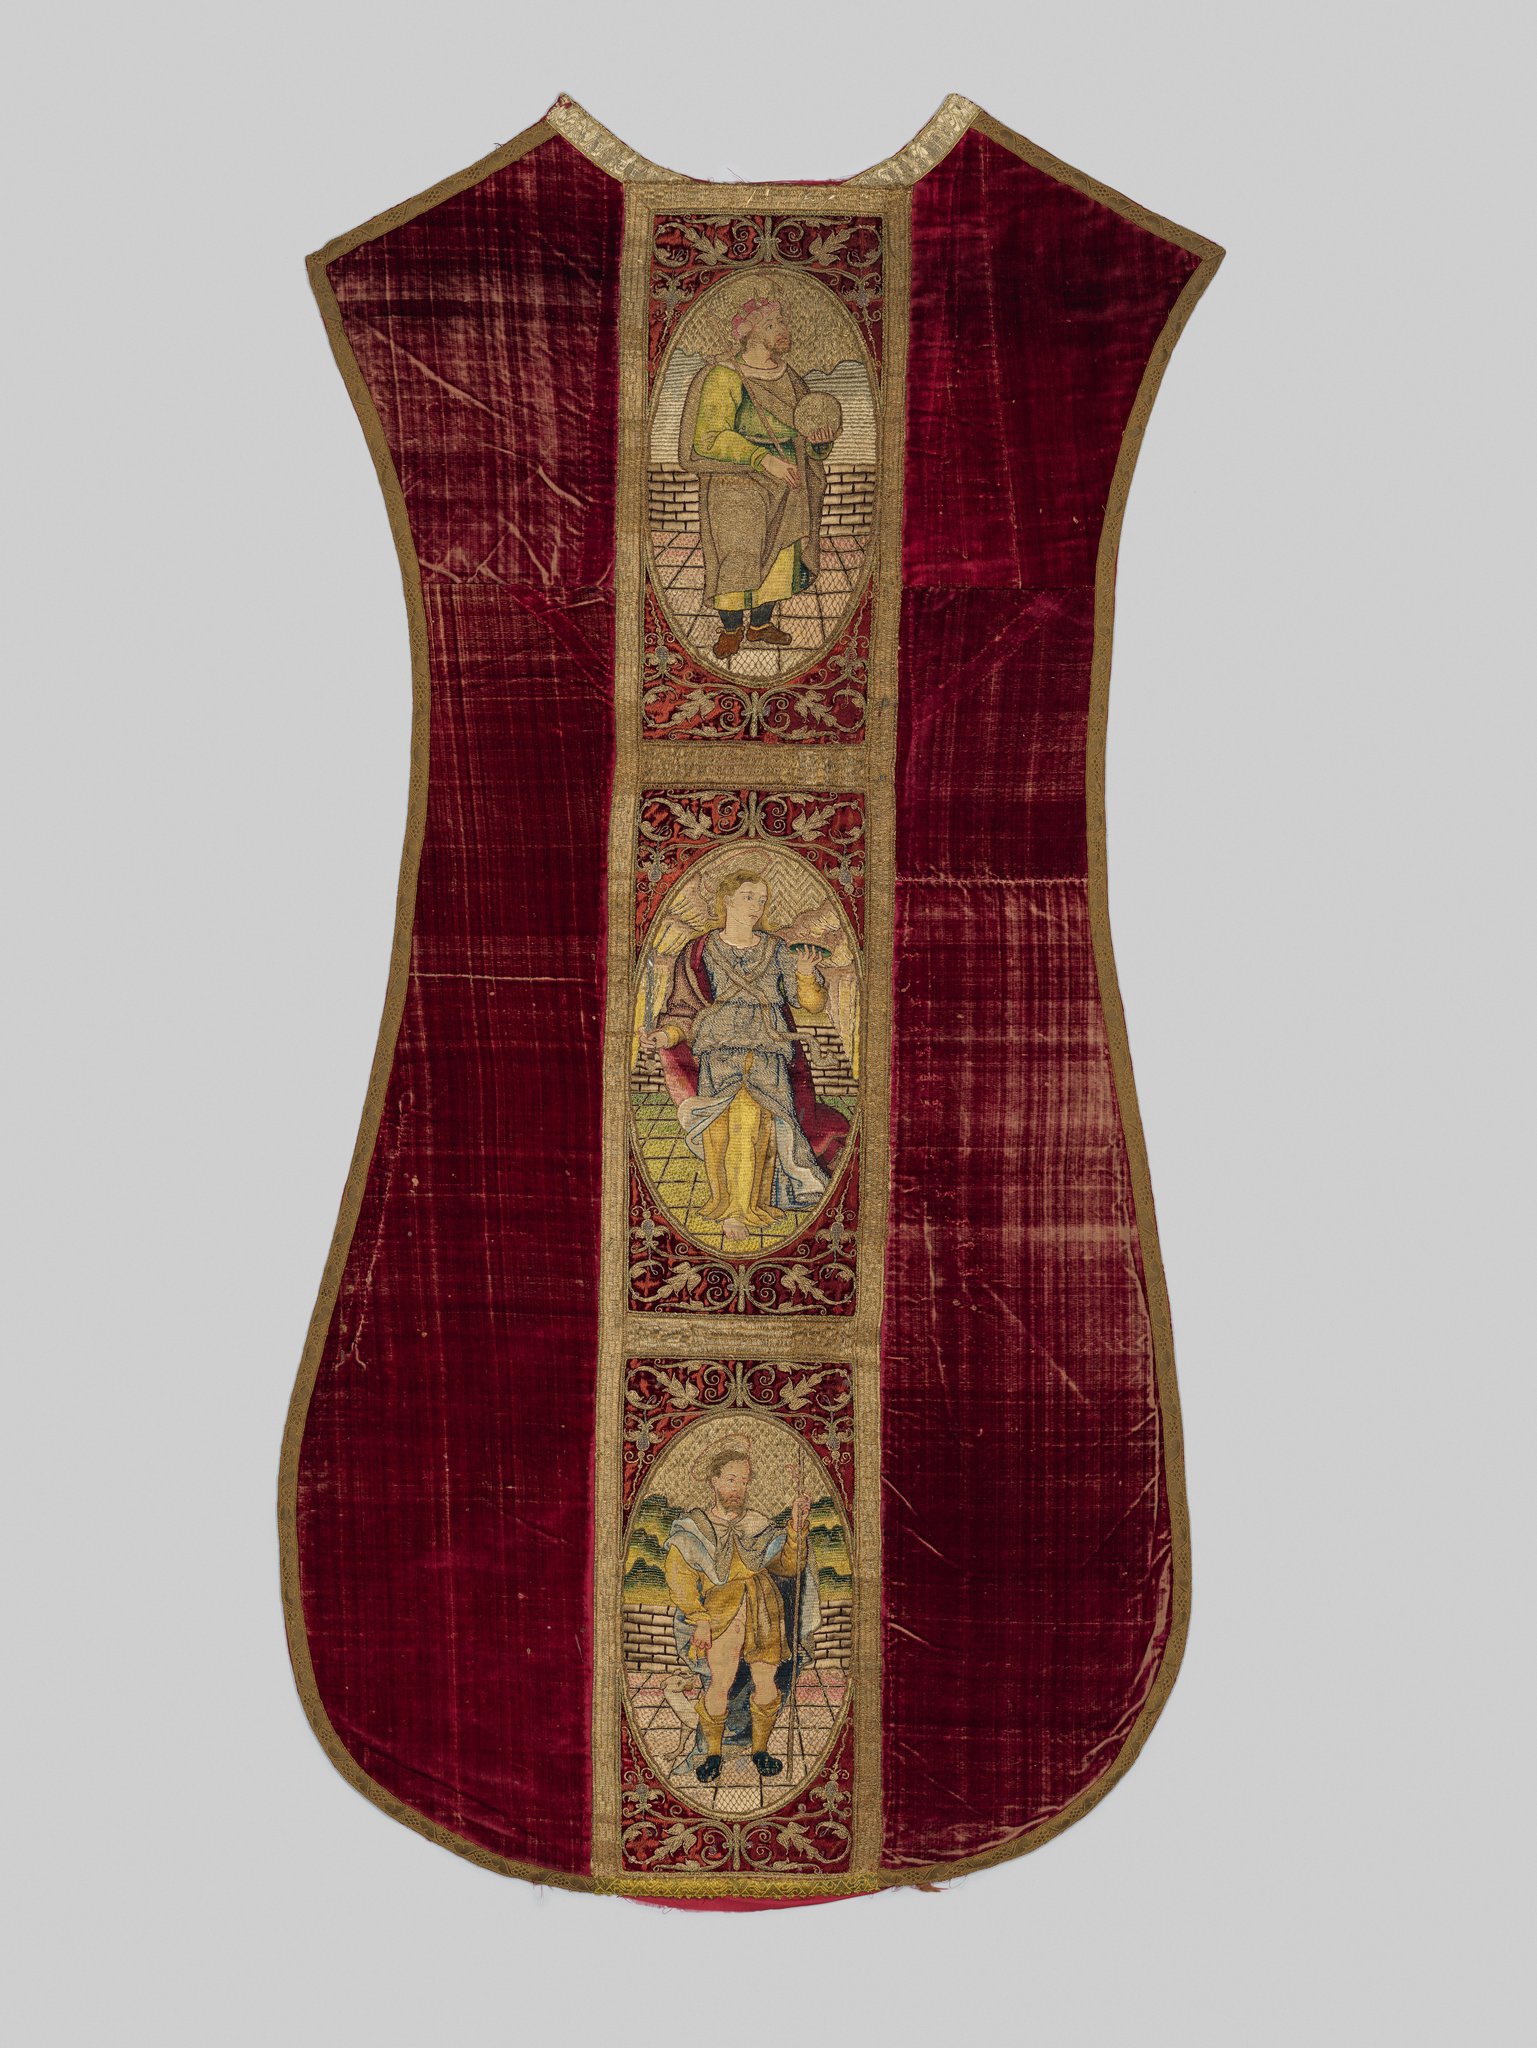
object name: chasuble with orphrey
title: Chasuble Back with an Orphrey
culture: italian or spanish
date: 1551-1600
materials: linen, metal, silk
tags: men,women